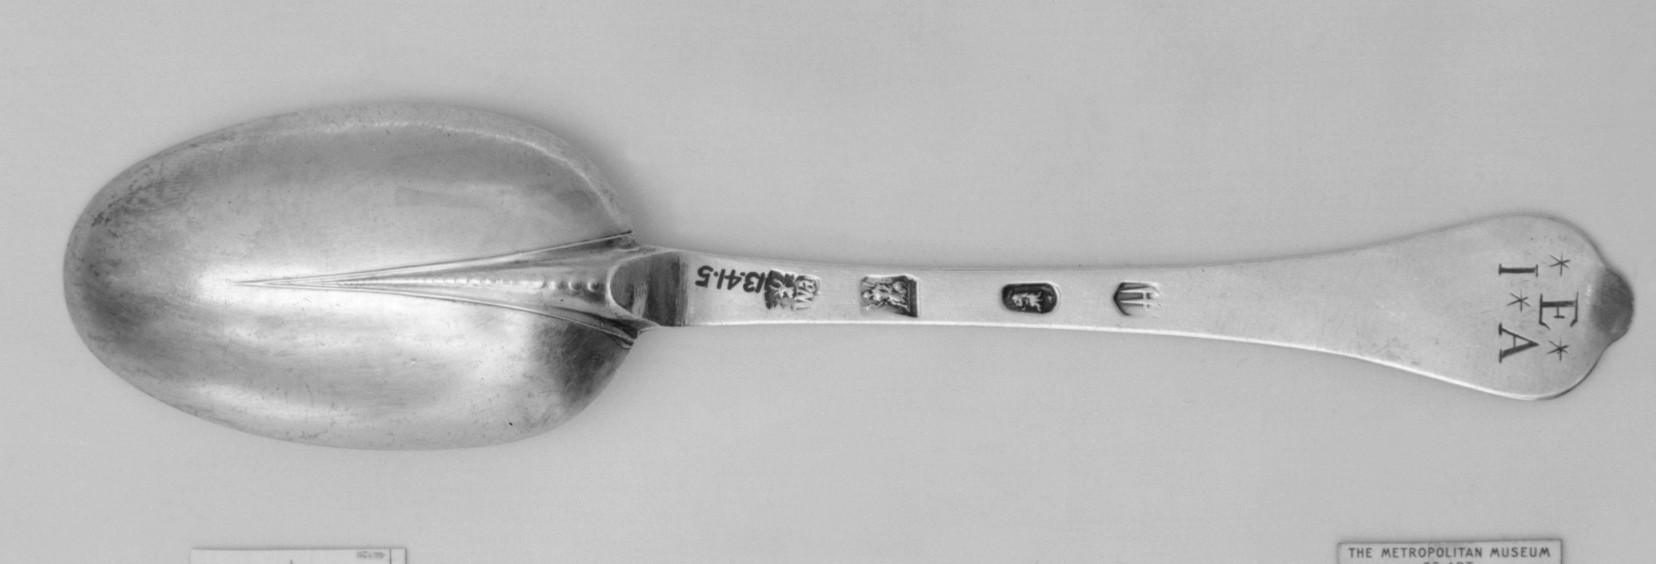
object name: spoon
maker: benjamin watts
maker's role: maker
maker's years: 1698-1727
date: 1701-1702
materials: silver